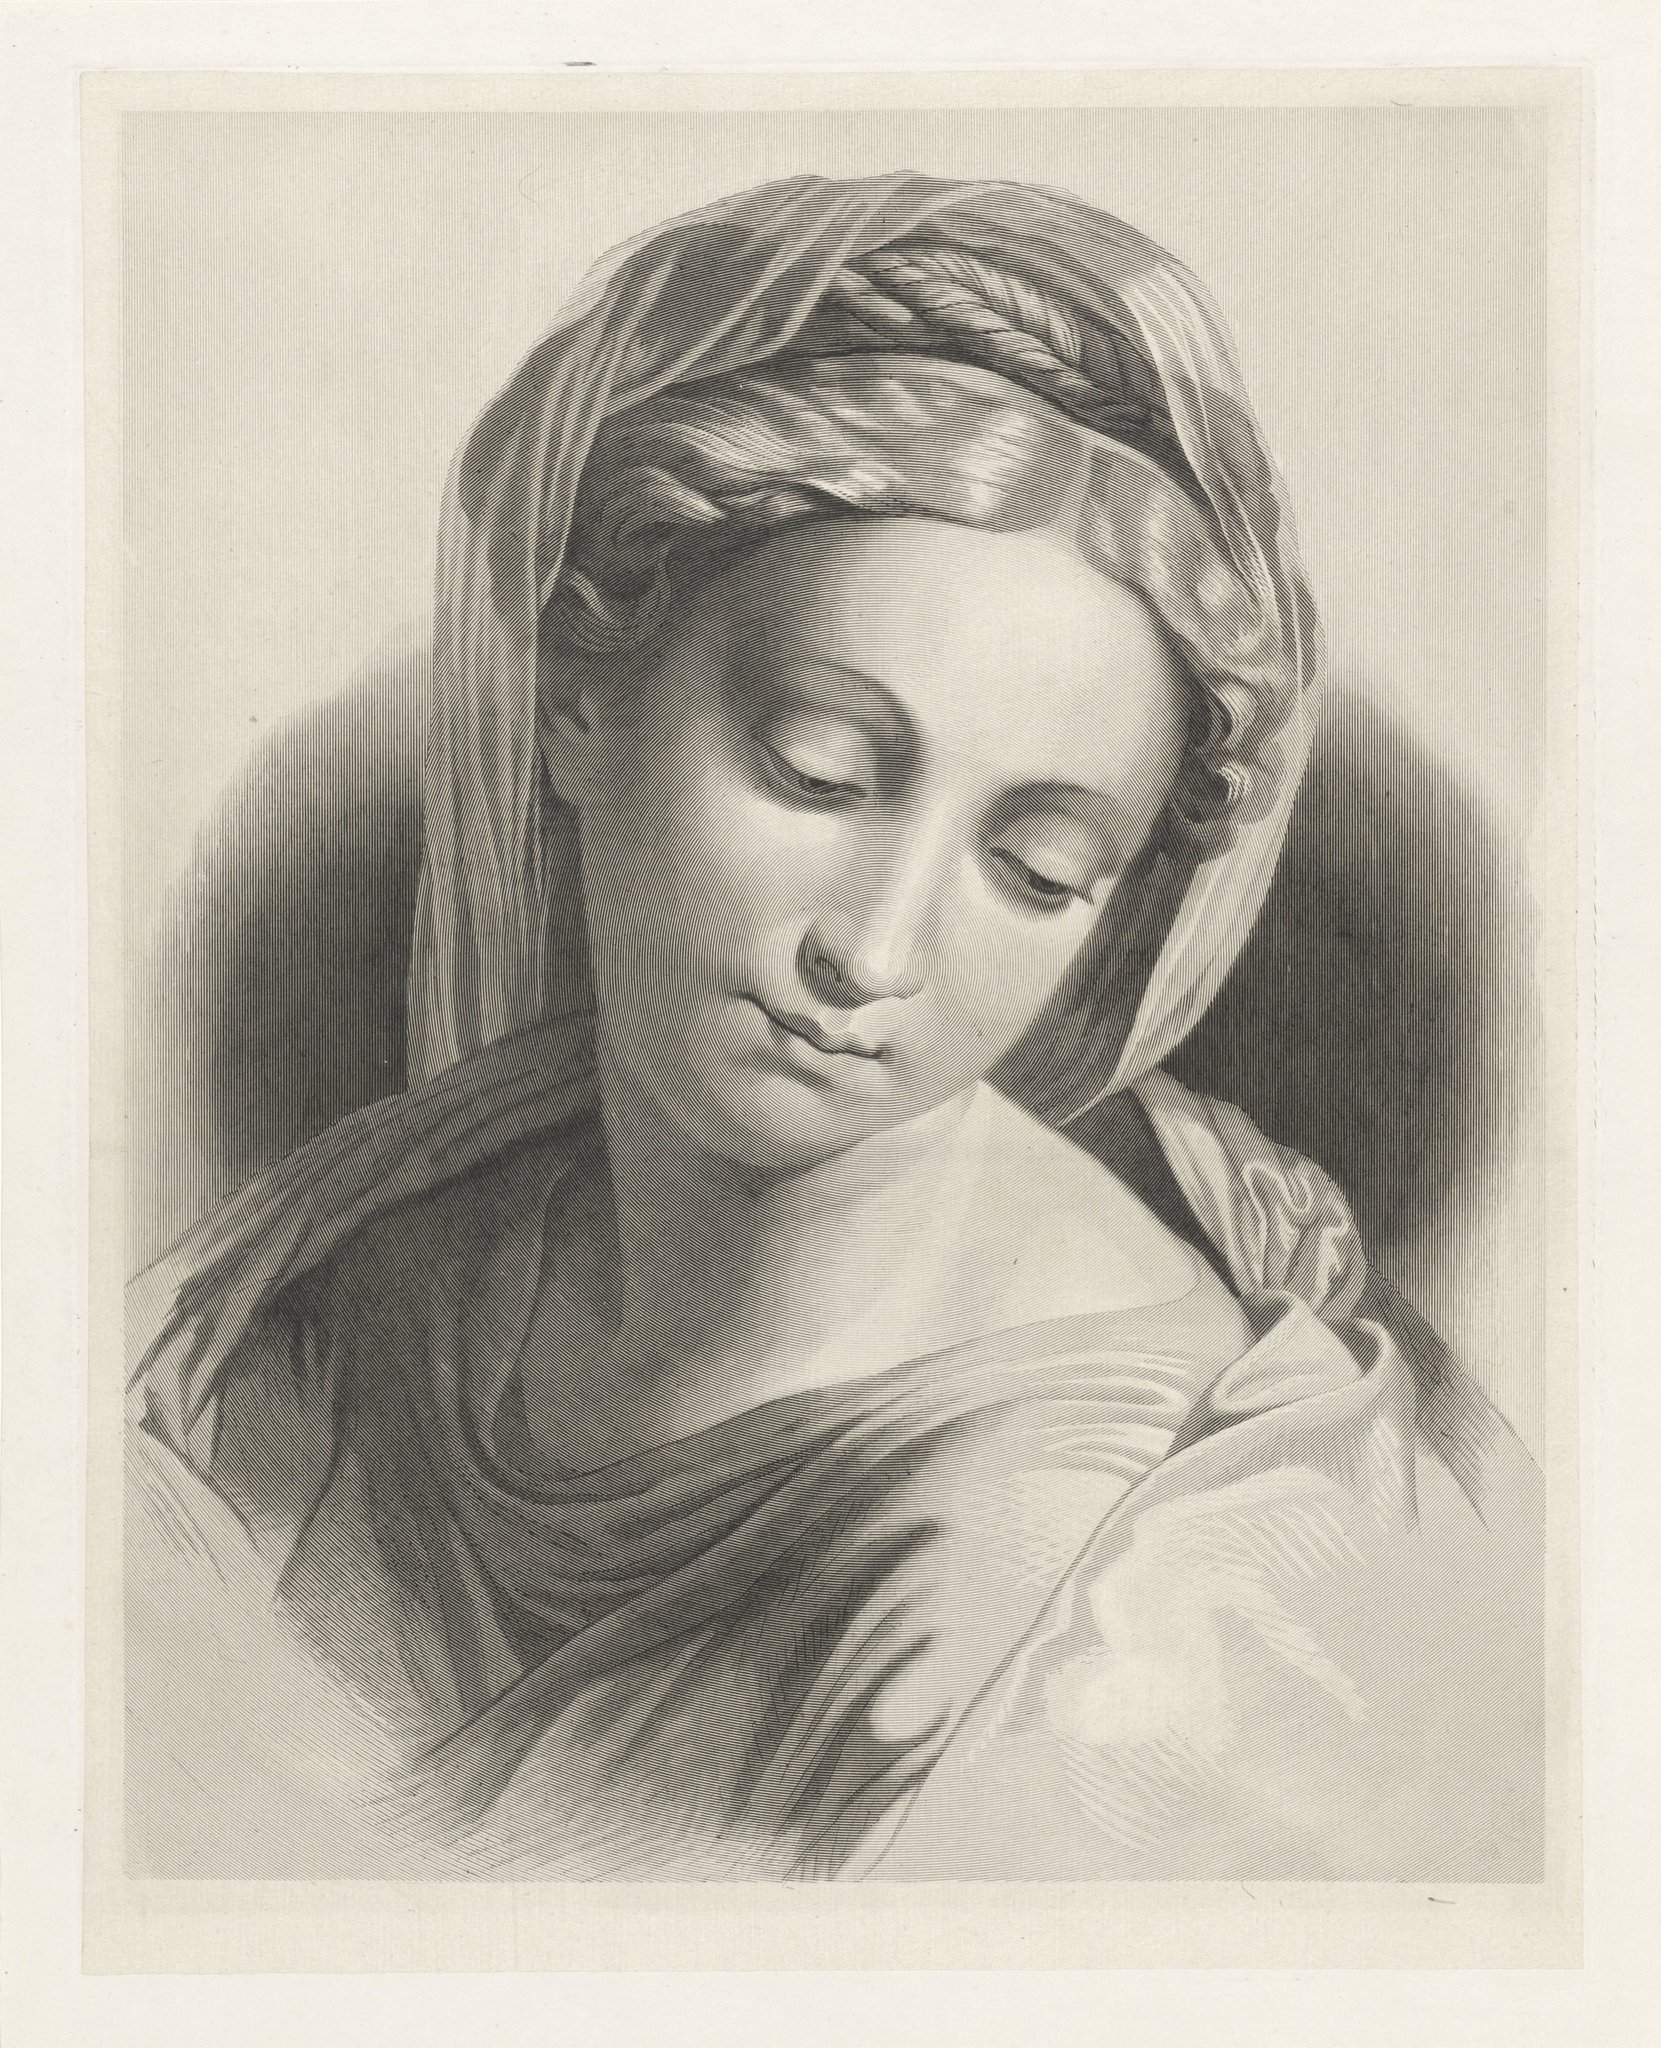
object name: print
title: Madonna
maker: dirk jurriaan sluyter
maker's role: draughtsman, print maker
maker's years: 1811-1886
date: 1826-1886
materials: paper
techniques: etching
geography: amsterdam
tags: 'portraits' of mary, veil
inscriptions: collector's mark: Lugt 2228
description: Maria met neergeslagen ogen. Op het hoofd draagt zij een sluier.